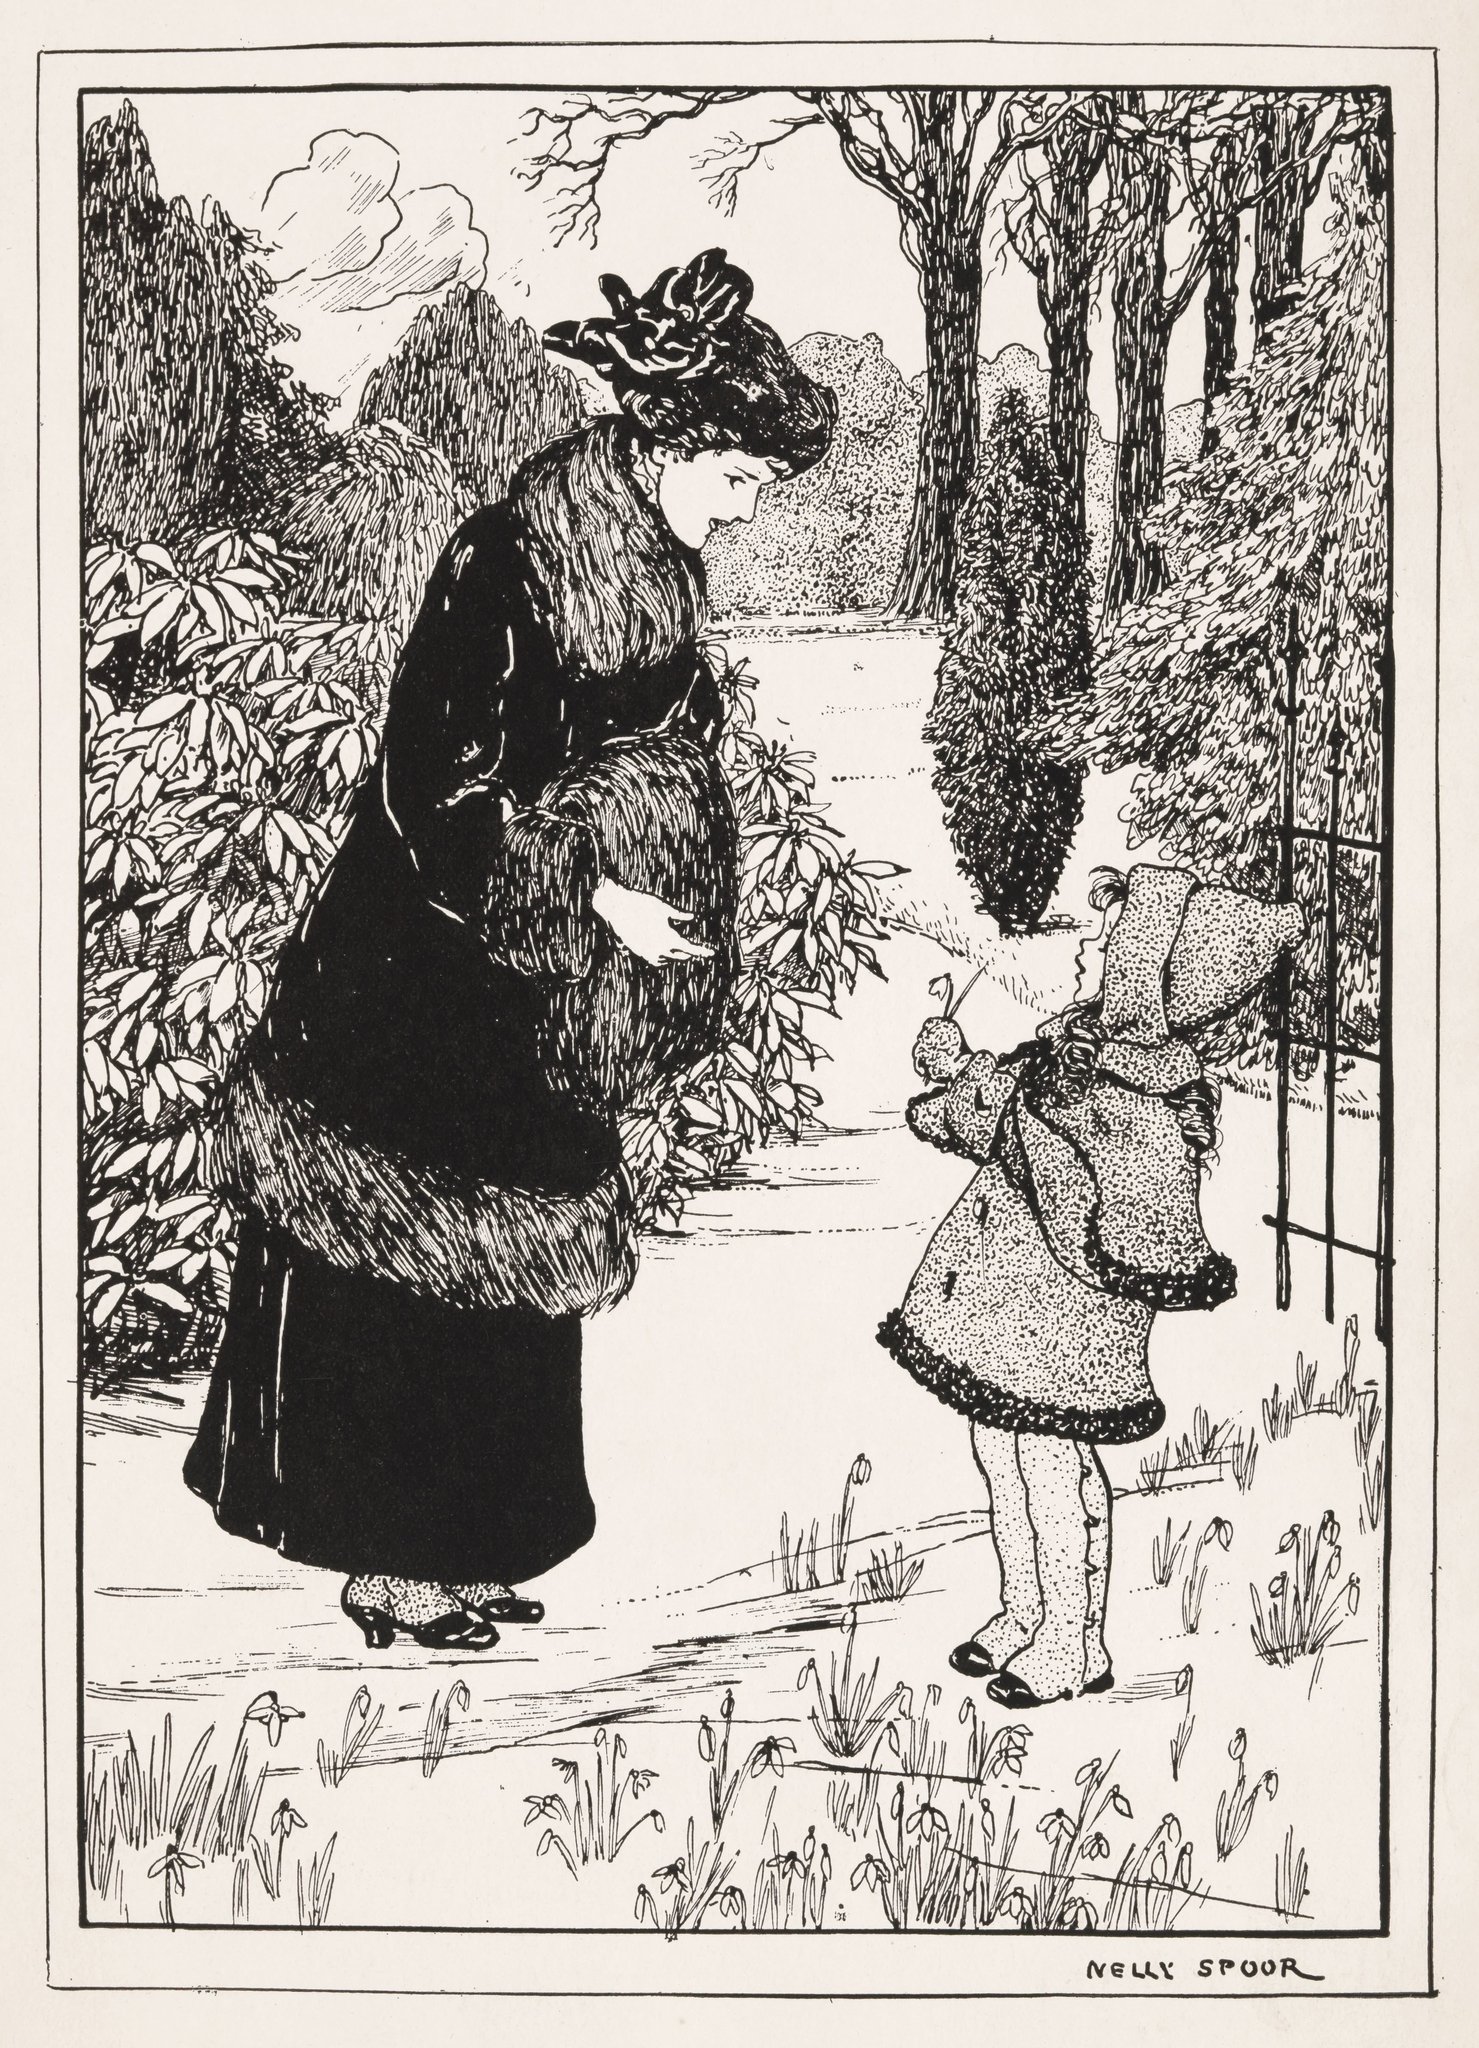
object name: photomechanical print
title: Meisje biedt een vrouw een sneeuwklokje aan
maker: Anonymous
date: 1916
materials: paper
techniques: printing block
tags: flowers, furrier, mother and child(ren), woman and child(ren) (family group)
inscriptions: signature: ‘NELLY SPOOR’, collector's mark: Lugt 2228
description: In een landschap met bomen en struiken staan een vrouw en meisje bij een hek. De vrouw draagt een met bont afgezette jas en heeft haar hand in een mof gestoken. Het meisje, dat tussen de sneeuwklokjes staat, biedt de vrouw een bloem aan.